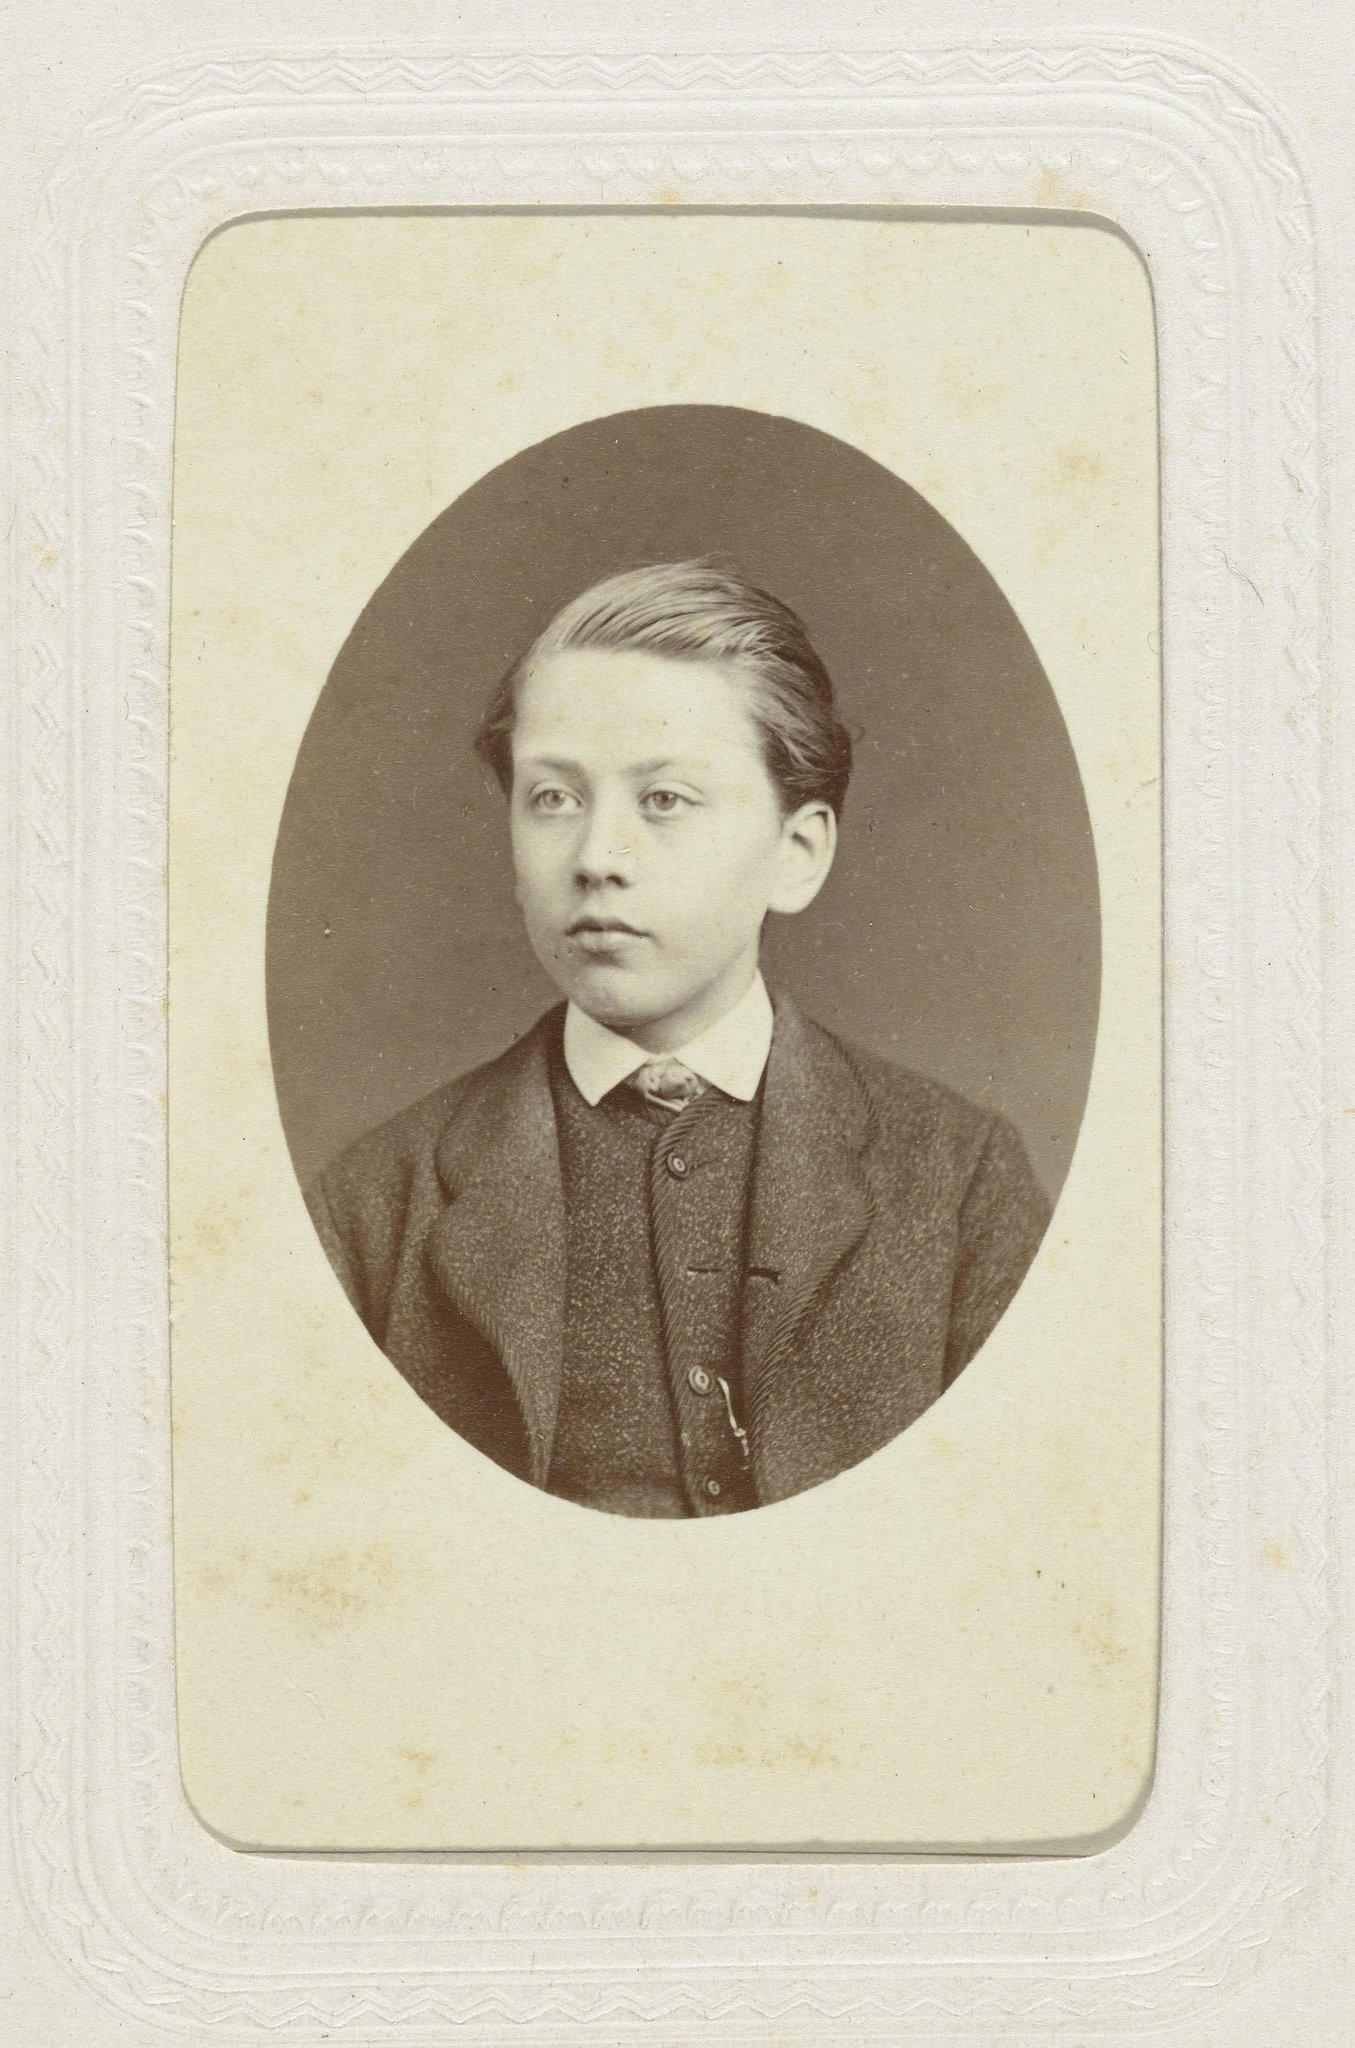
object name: carte de visite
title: Studioportret van een jongetje in pak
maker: bernardus bruining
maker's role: fotograaf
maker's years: 1834-1900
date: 1863-1866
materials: cardboard, paper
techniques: albumen print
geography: leiden